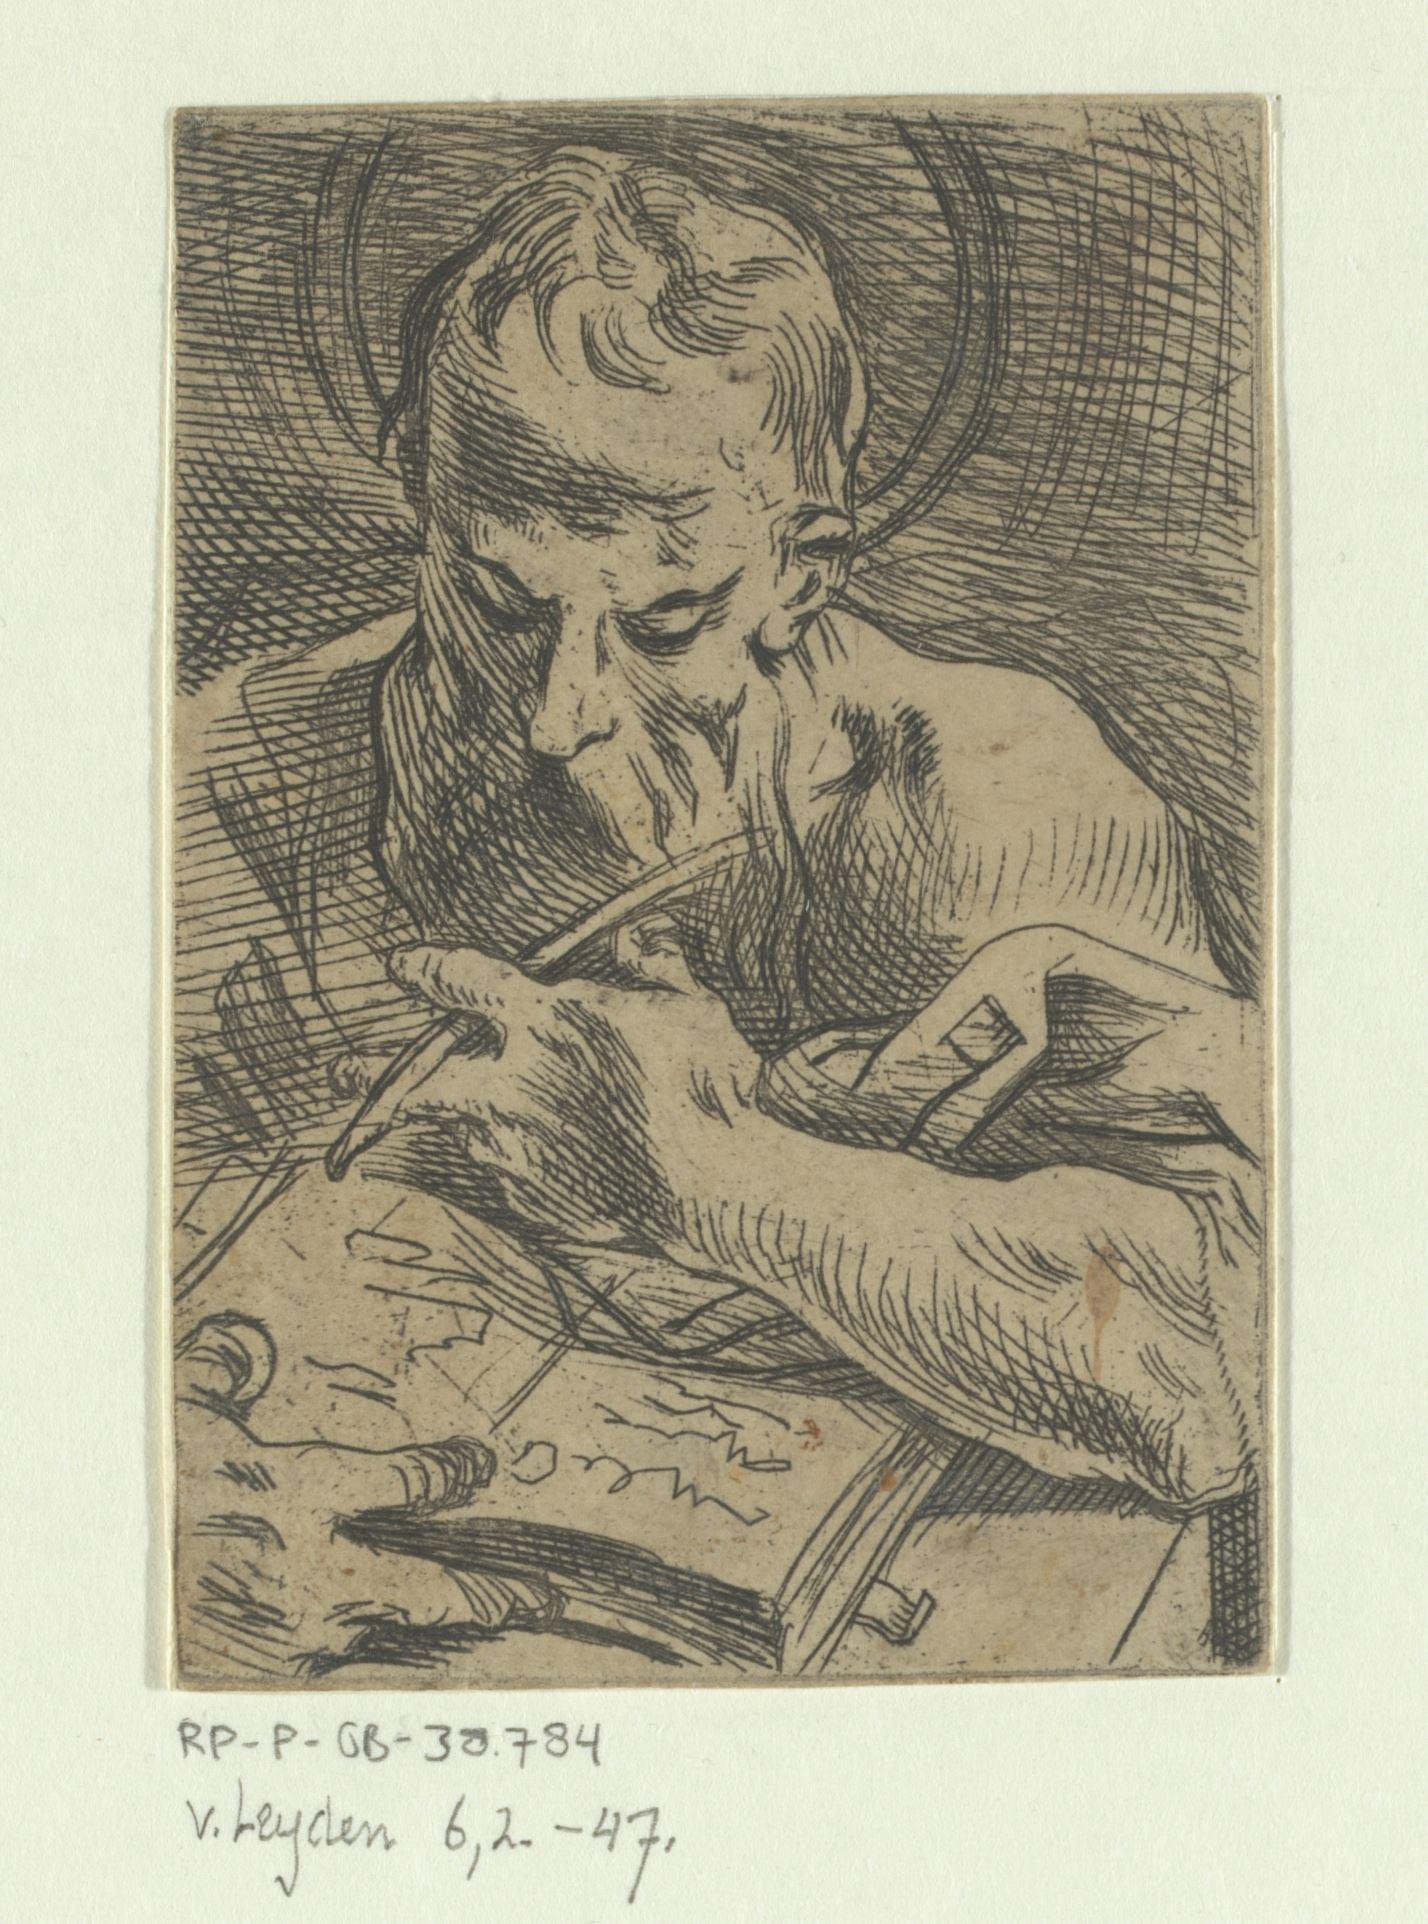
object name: print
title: Schrijvende evangelist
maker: Anonymous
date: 1600-1699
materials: paper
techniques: etching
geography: italy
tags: evangelists, usually with books or scrolls (not in biblical context)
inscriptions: collector's mark: Lugt 240, inscription: ‘6,2. - 47.’